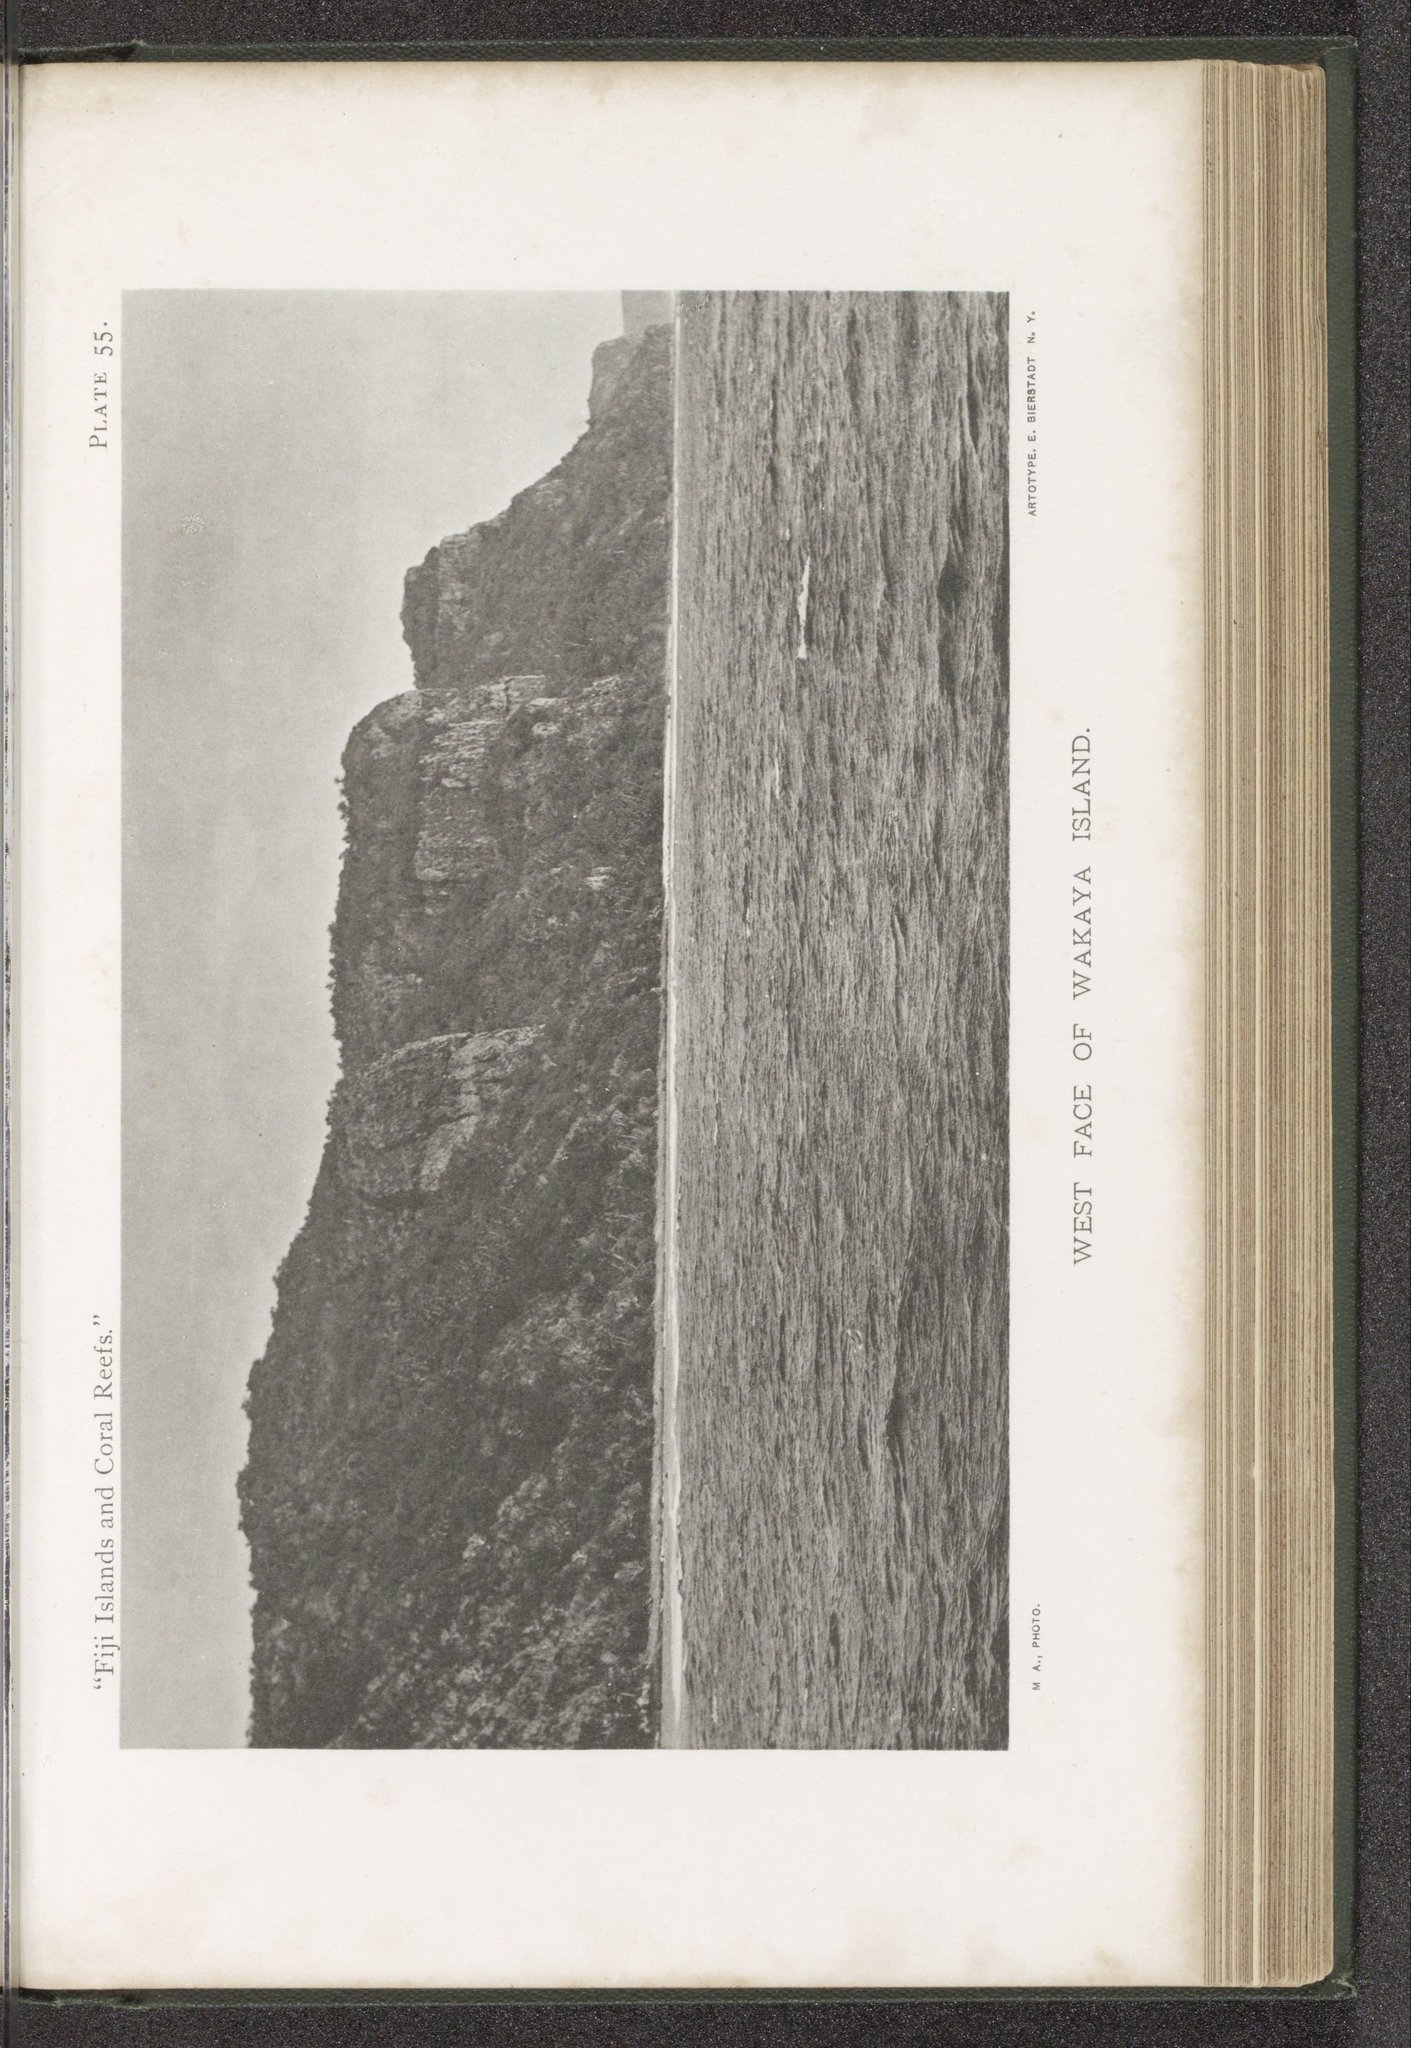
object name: photomechanical print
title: Gezicht op de westkant van Wakaya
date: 1885-1899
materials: paper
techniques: photograph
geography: new york city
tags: island, ocean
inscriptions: name: ‘M A., Photo.’, name: ‘Artotype. E. Bierstadt N. Y.’, number: ‘Plate 55.’